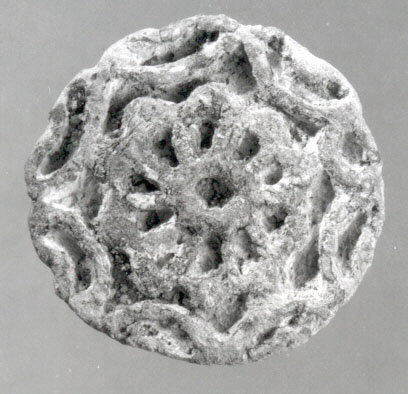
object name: stamp seal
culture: bactria-margiana archaeological complex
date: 2333-1668 BCE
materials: copper alloy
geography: bactria-margiana